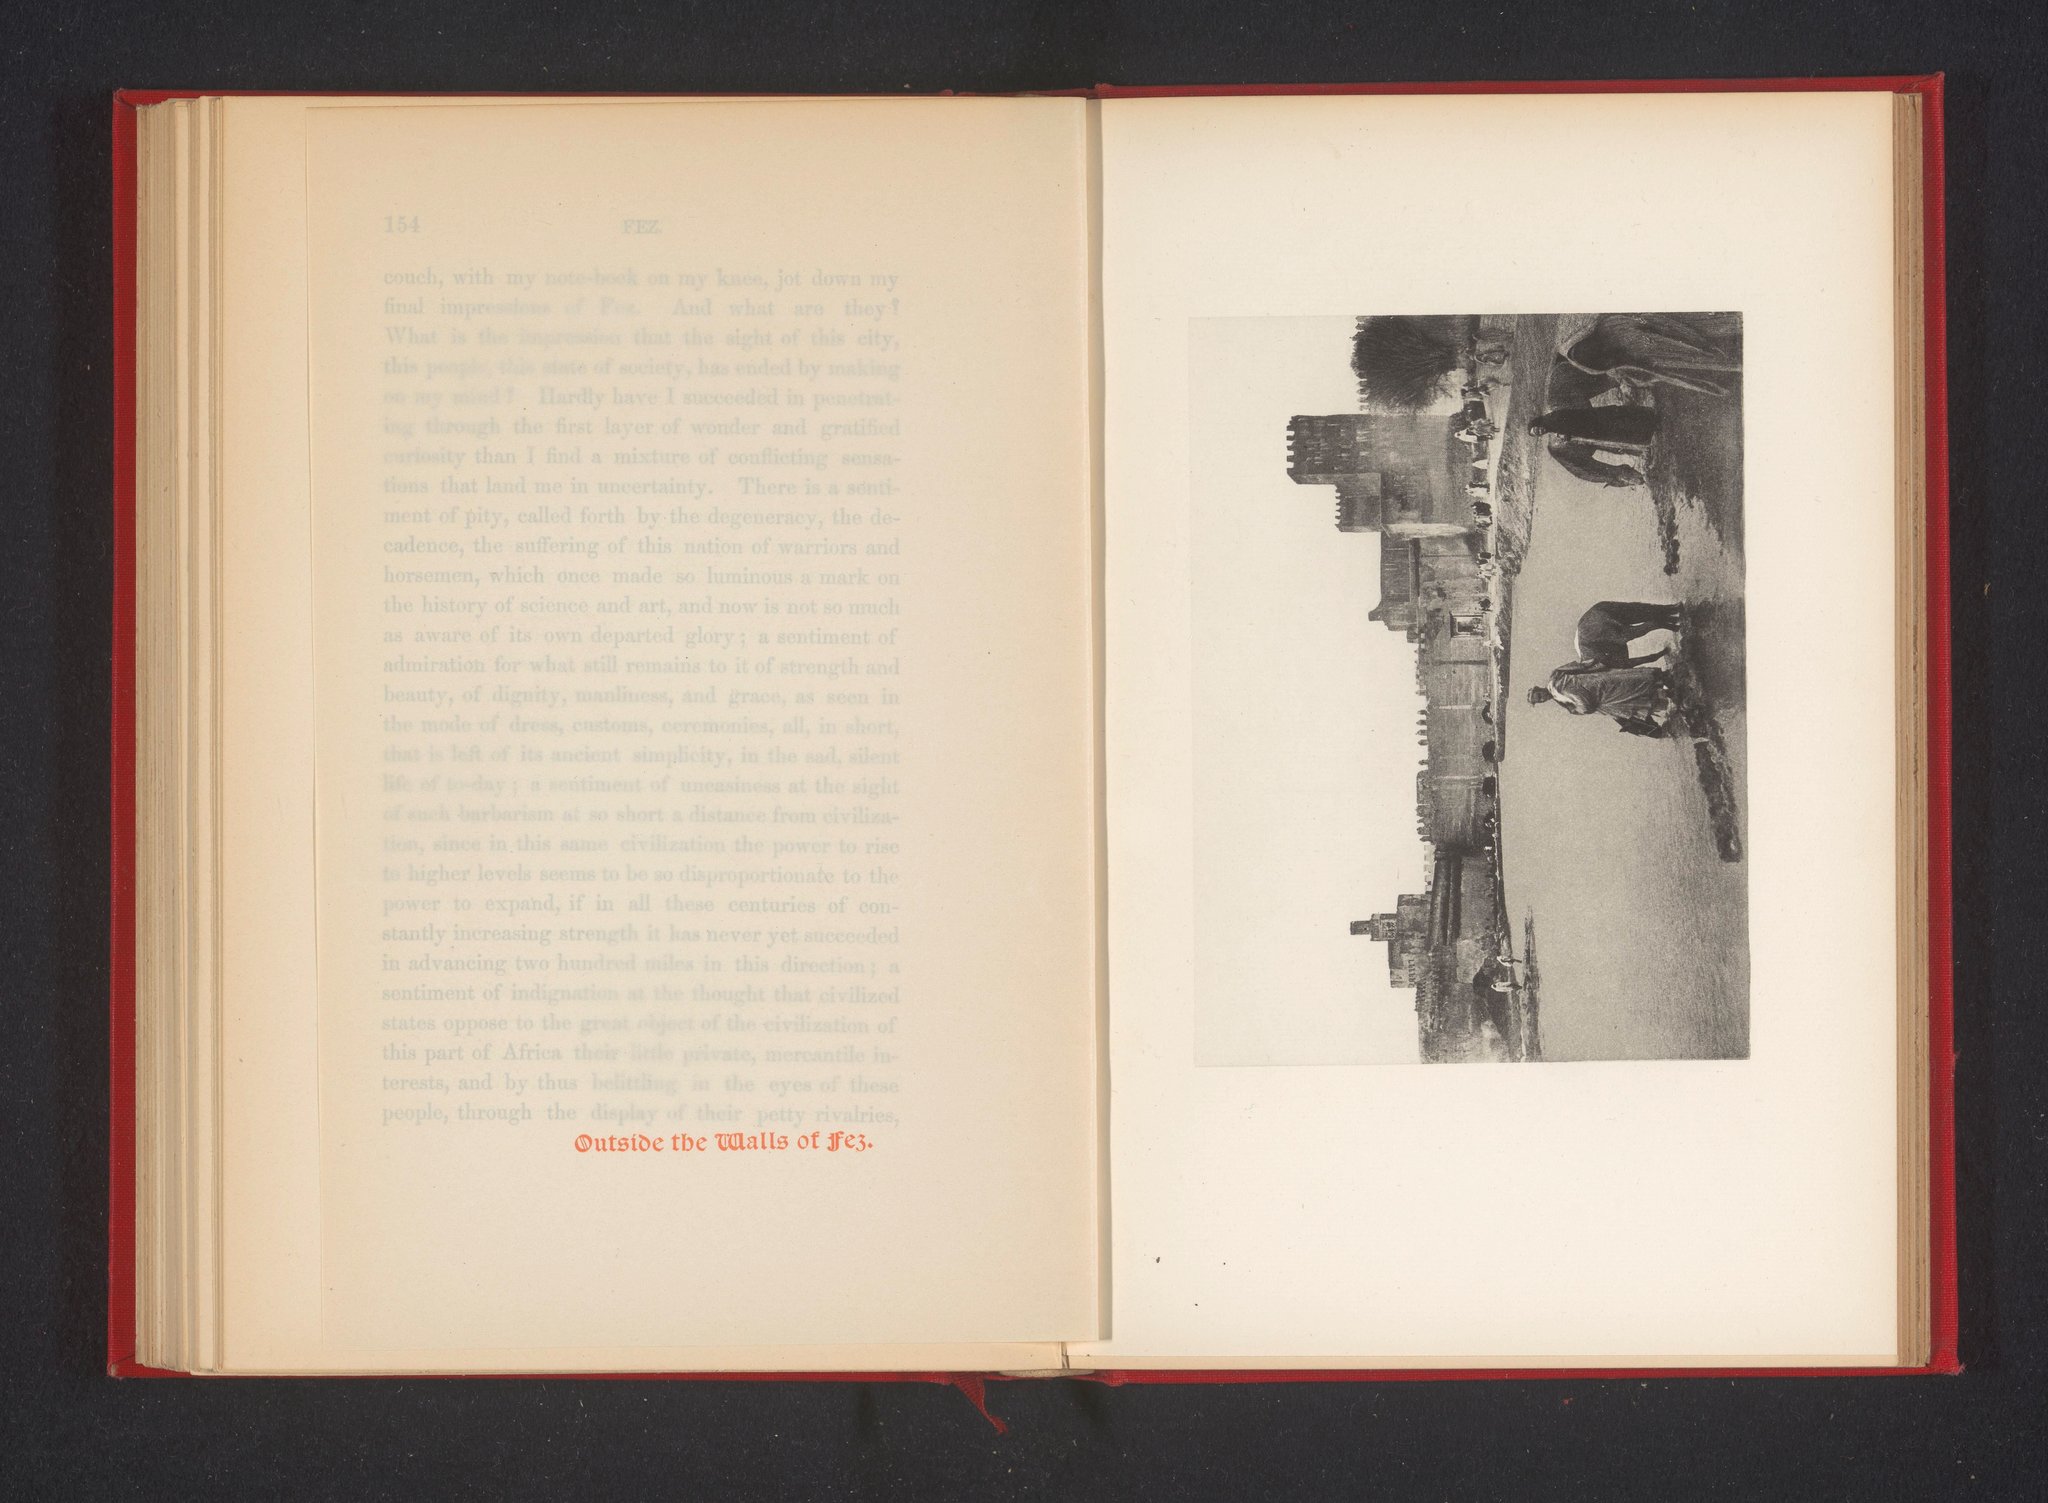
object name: photomechanical print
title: Meer buiten de stadsmuren van Fez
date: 1887-1897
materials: paper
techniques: photoaquatint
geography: morocco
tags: lake, city-walls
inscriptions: title: ‘Outside the Walls of Fez.’